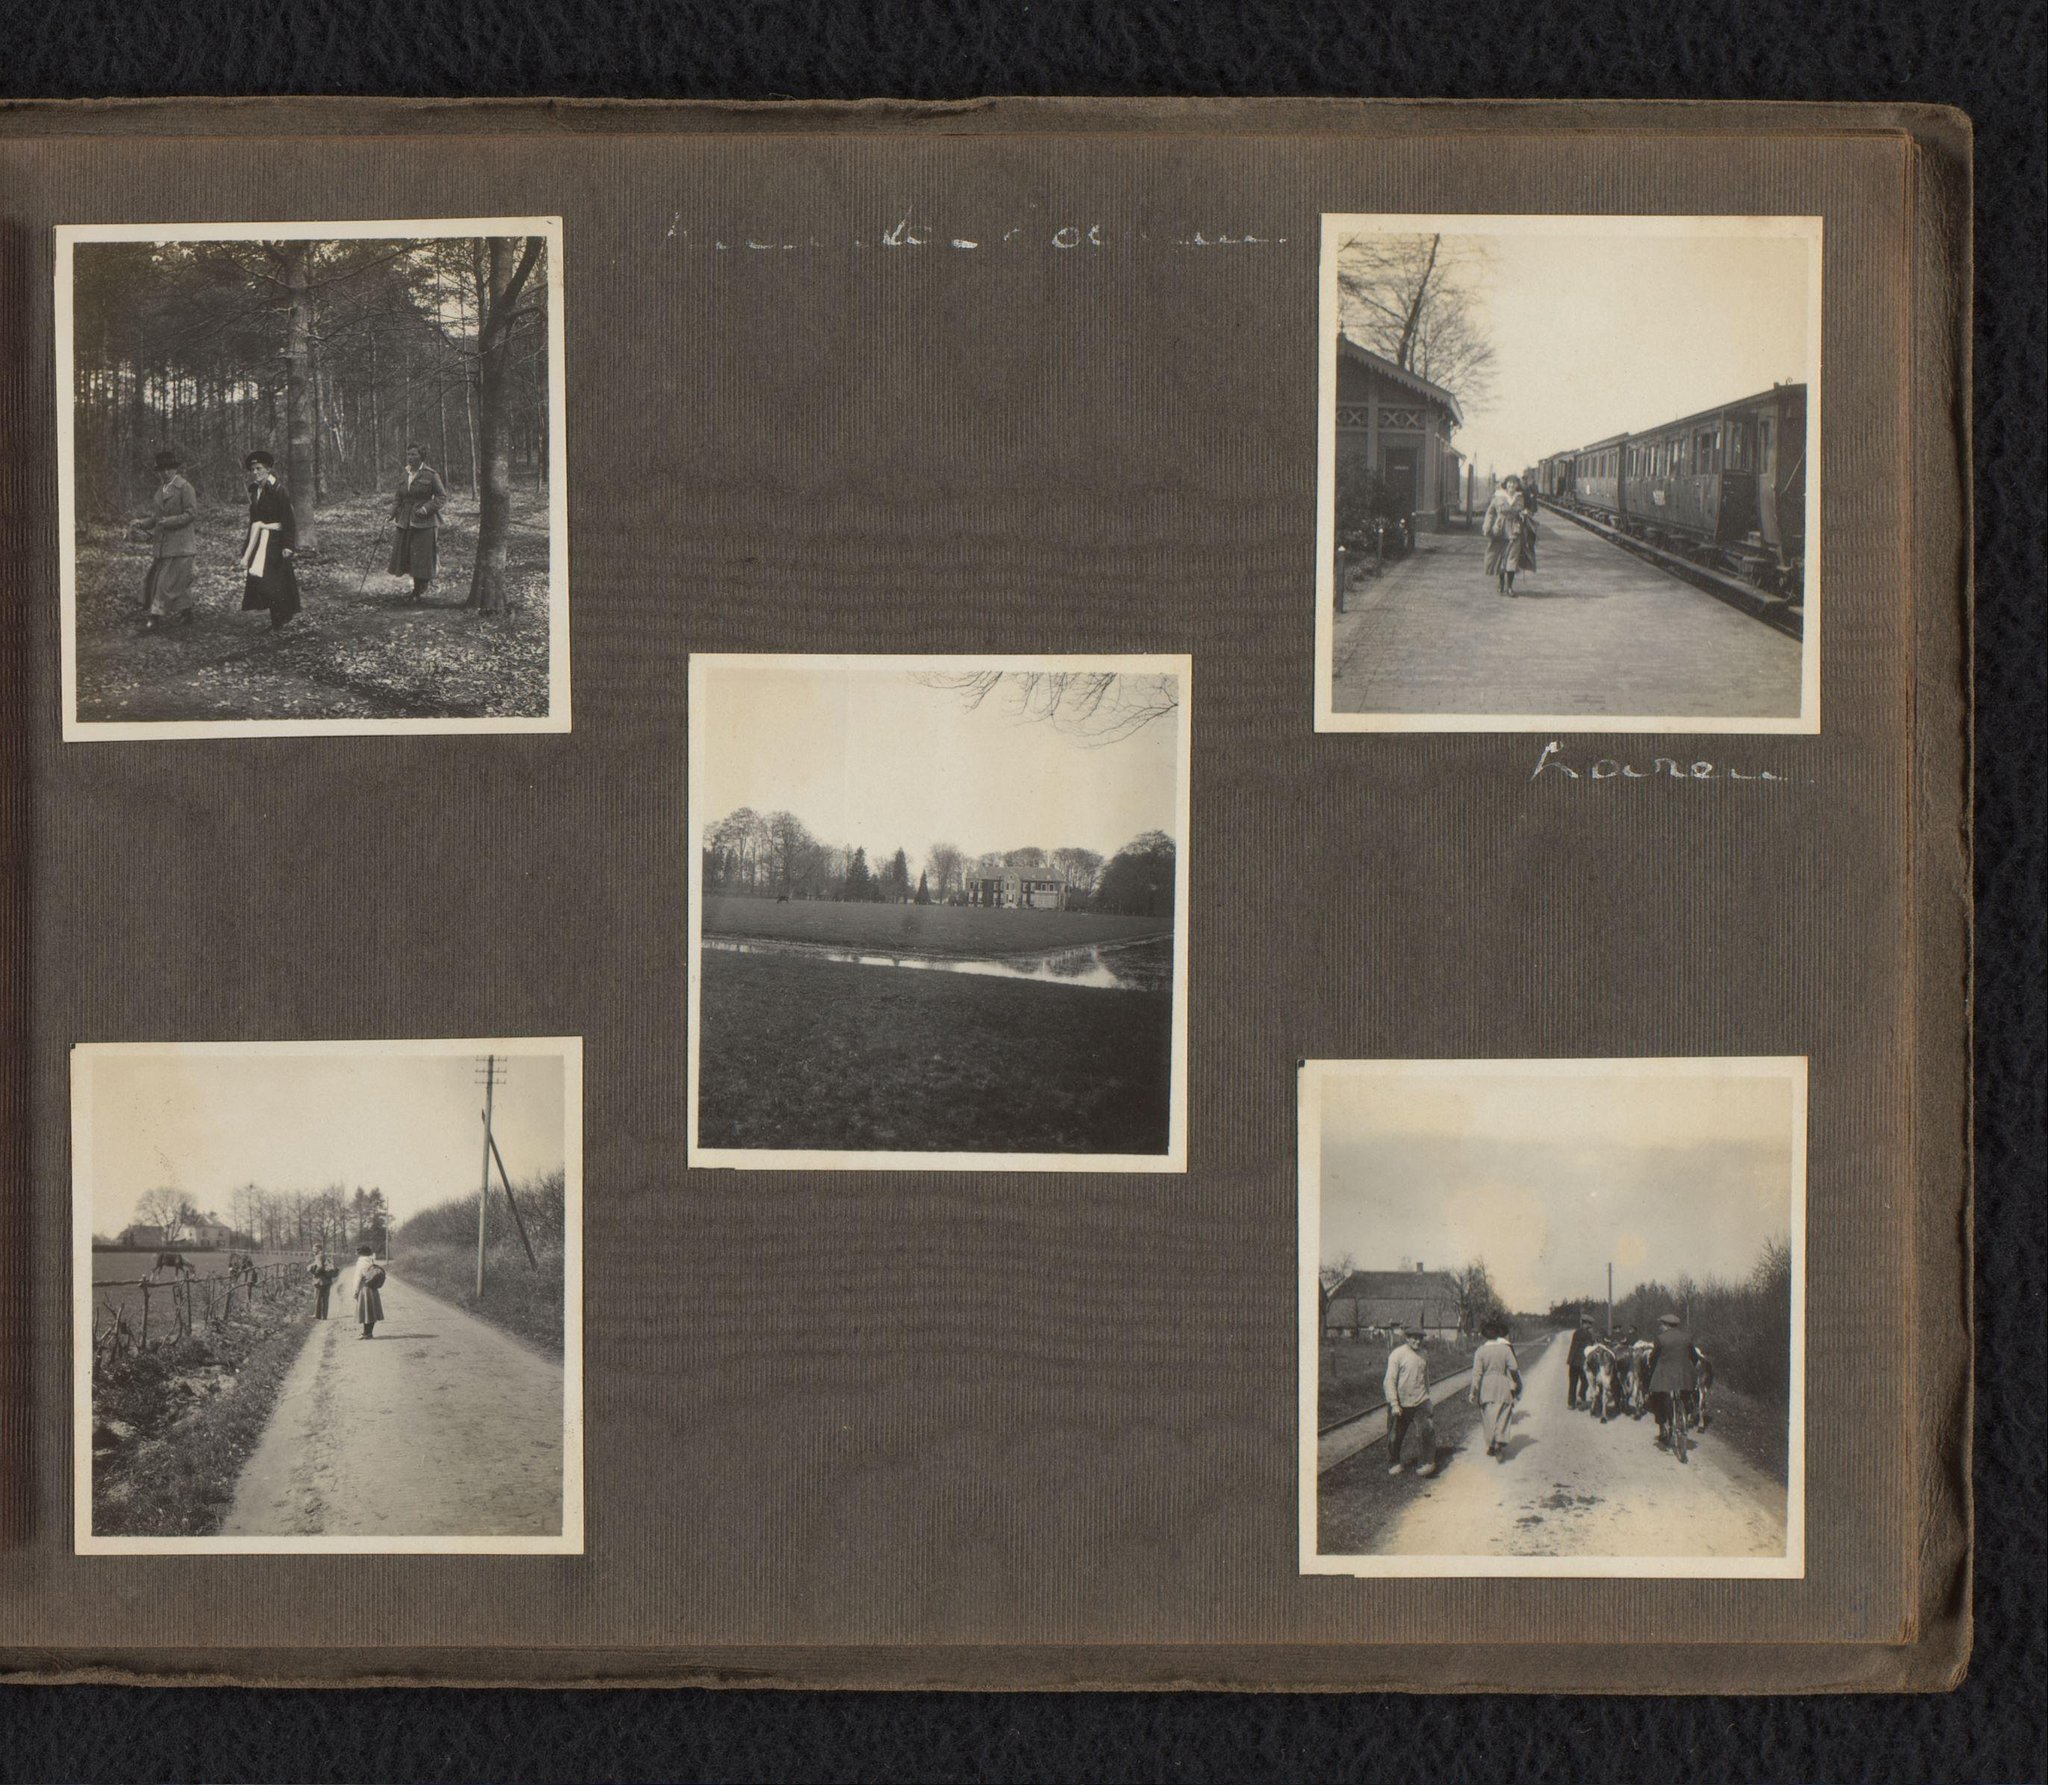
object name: album leaf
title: Vijf foto's van familie Onnen-Van den Berg tijdens een wandeling bij Laren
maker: Anonymous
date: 1904-1917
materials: paper, cardboard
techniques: gelatin silver print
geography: laren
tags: walking, hiking (recreation), passenger train, landscape with tower or castle, family life, farm or solitary house in landscape (+ city(-scape) with figures, staffage)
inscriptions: caption: ‘[...]/ Laren’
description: Deze foto's maken deel uit van een album.